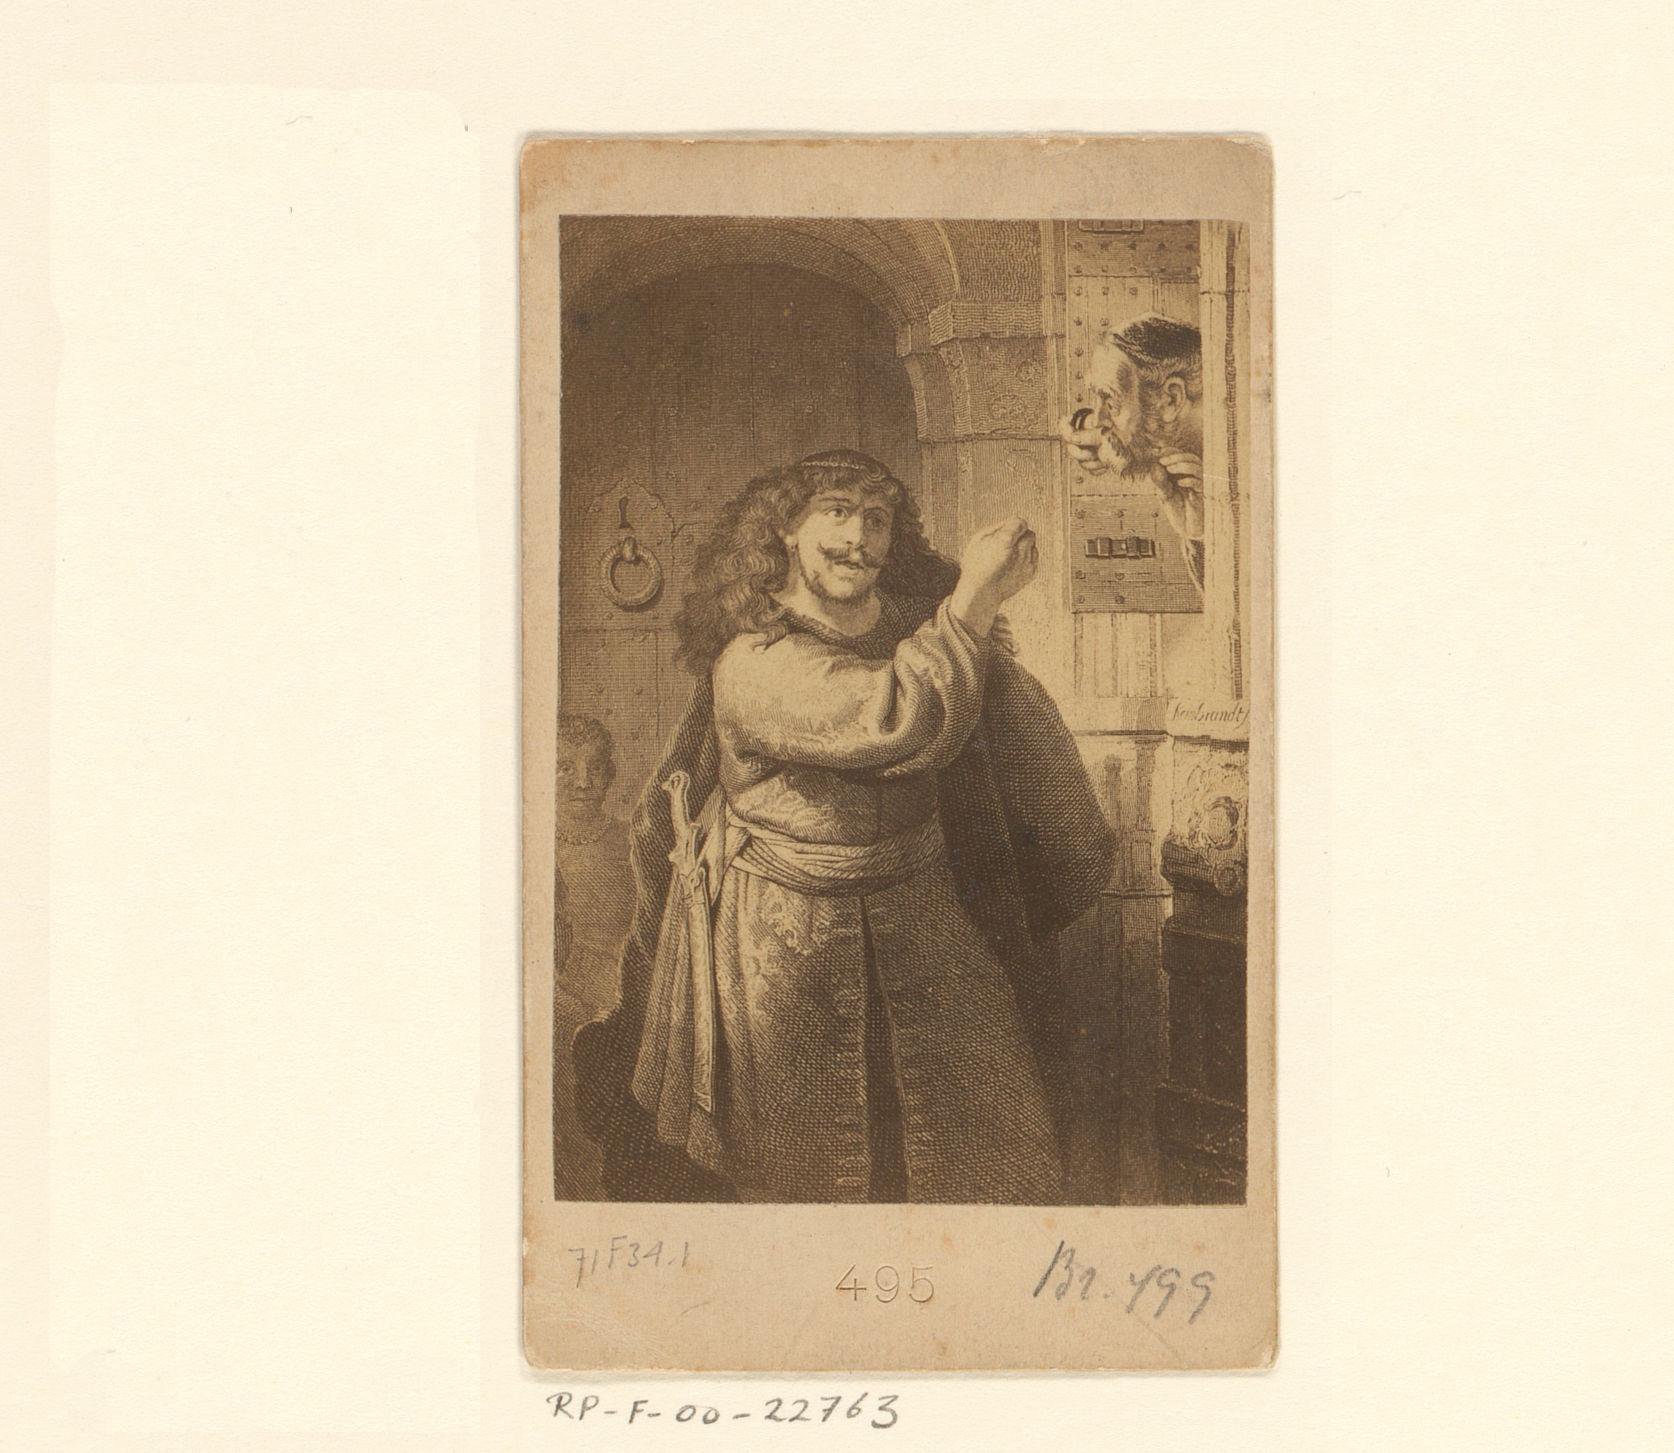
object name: reproduction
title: Fotoreproductie van een prent van een man die aanklopt bij een huis door Rembrandt van Rijn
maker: Anonymous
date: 1860-1890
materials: cardboard, paper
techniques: albumen print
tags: knocking at the door, human figure at (open) window, seen from outside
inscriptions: stamp: ‘ICON’, inscription: ‘71F34.1/ Br. 499’, number: ‘495’